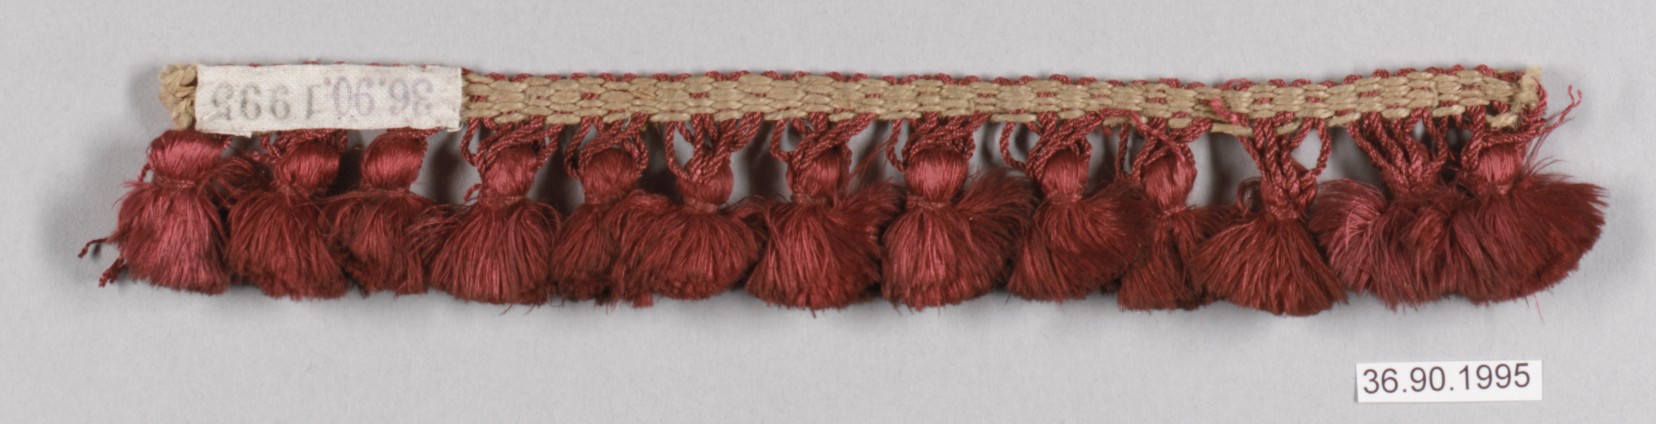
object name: fringe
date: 1801-1833